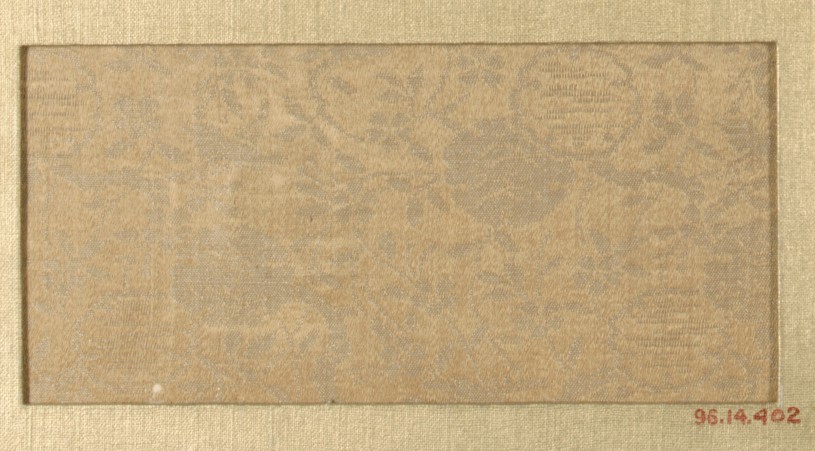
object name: piece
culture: japanese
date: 1701-1900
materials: silk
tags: leaves